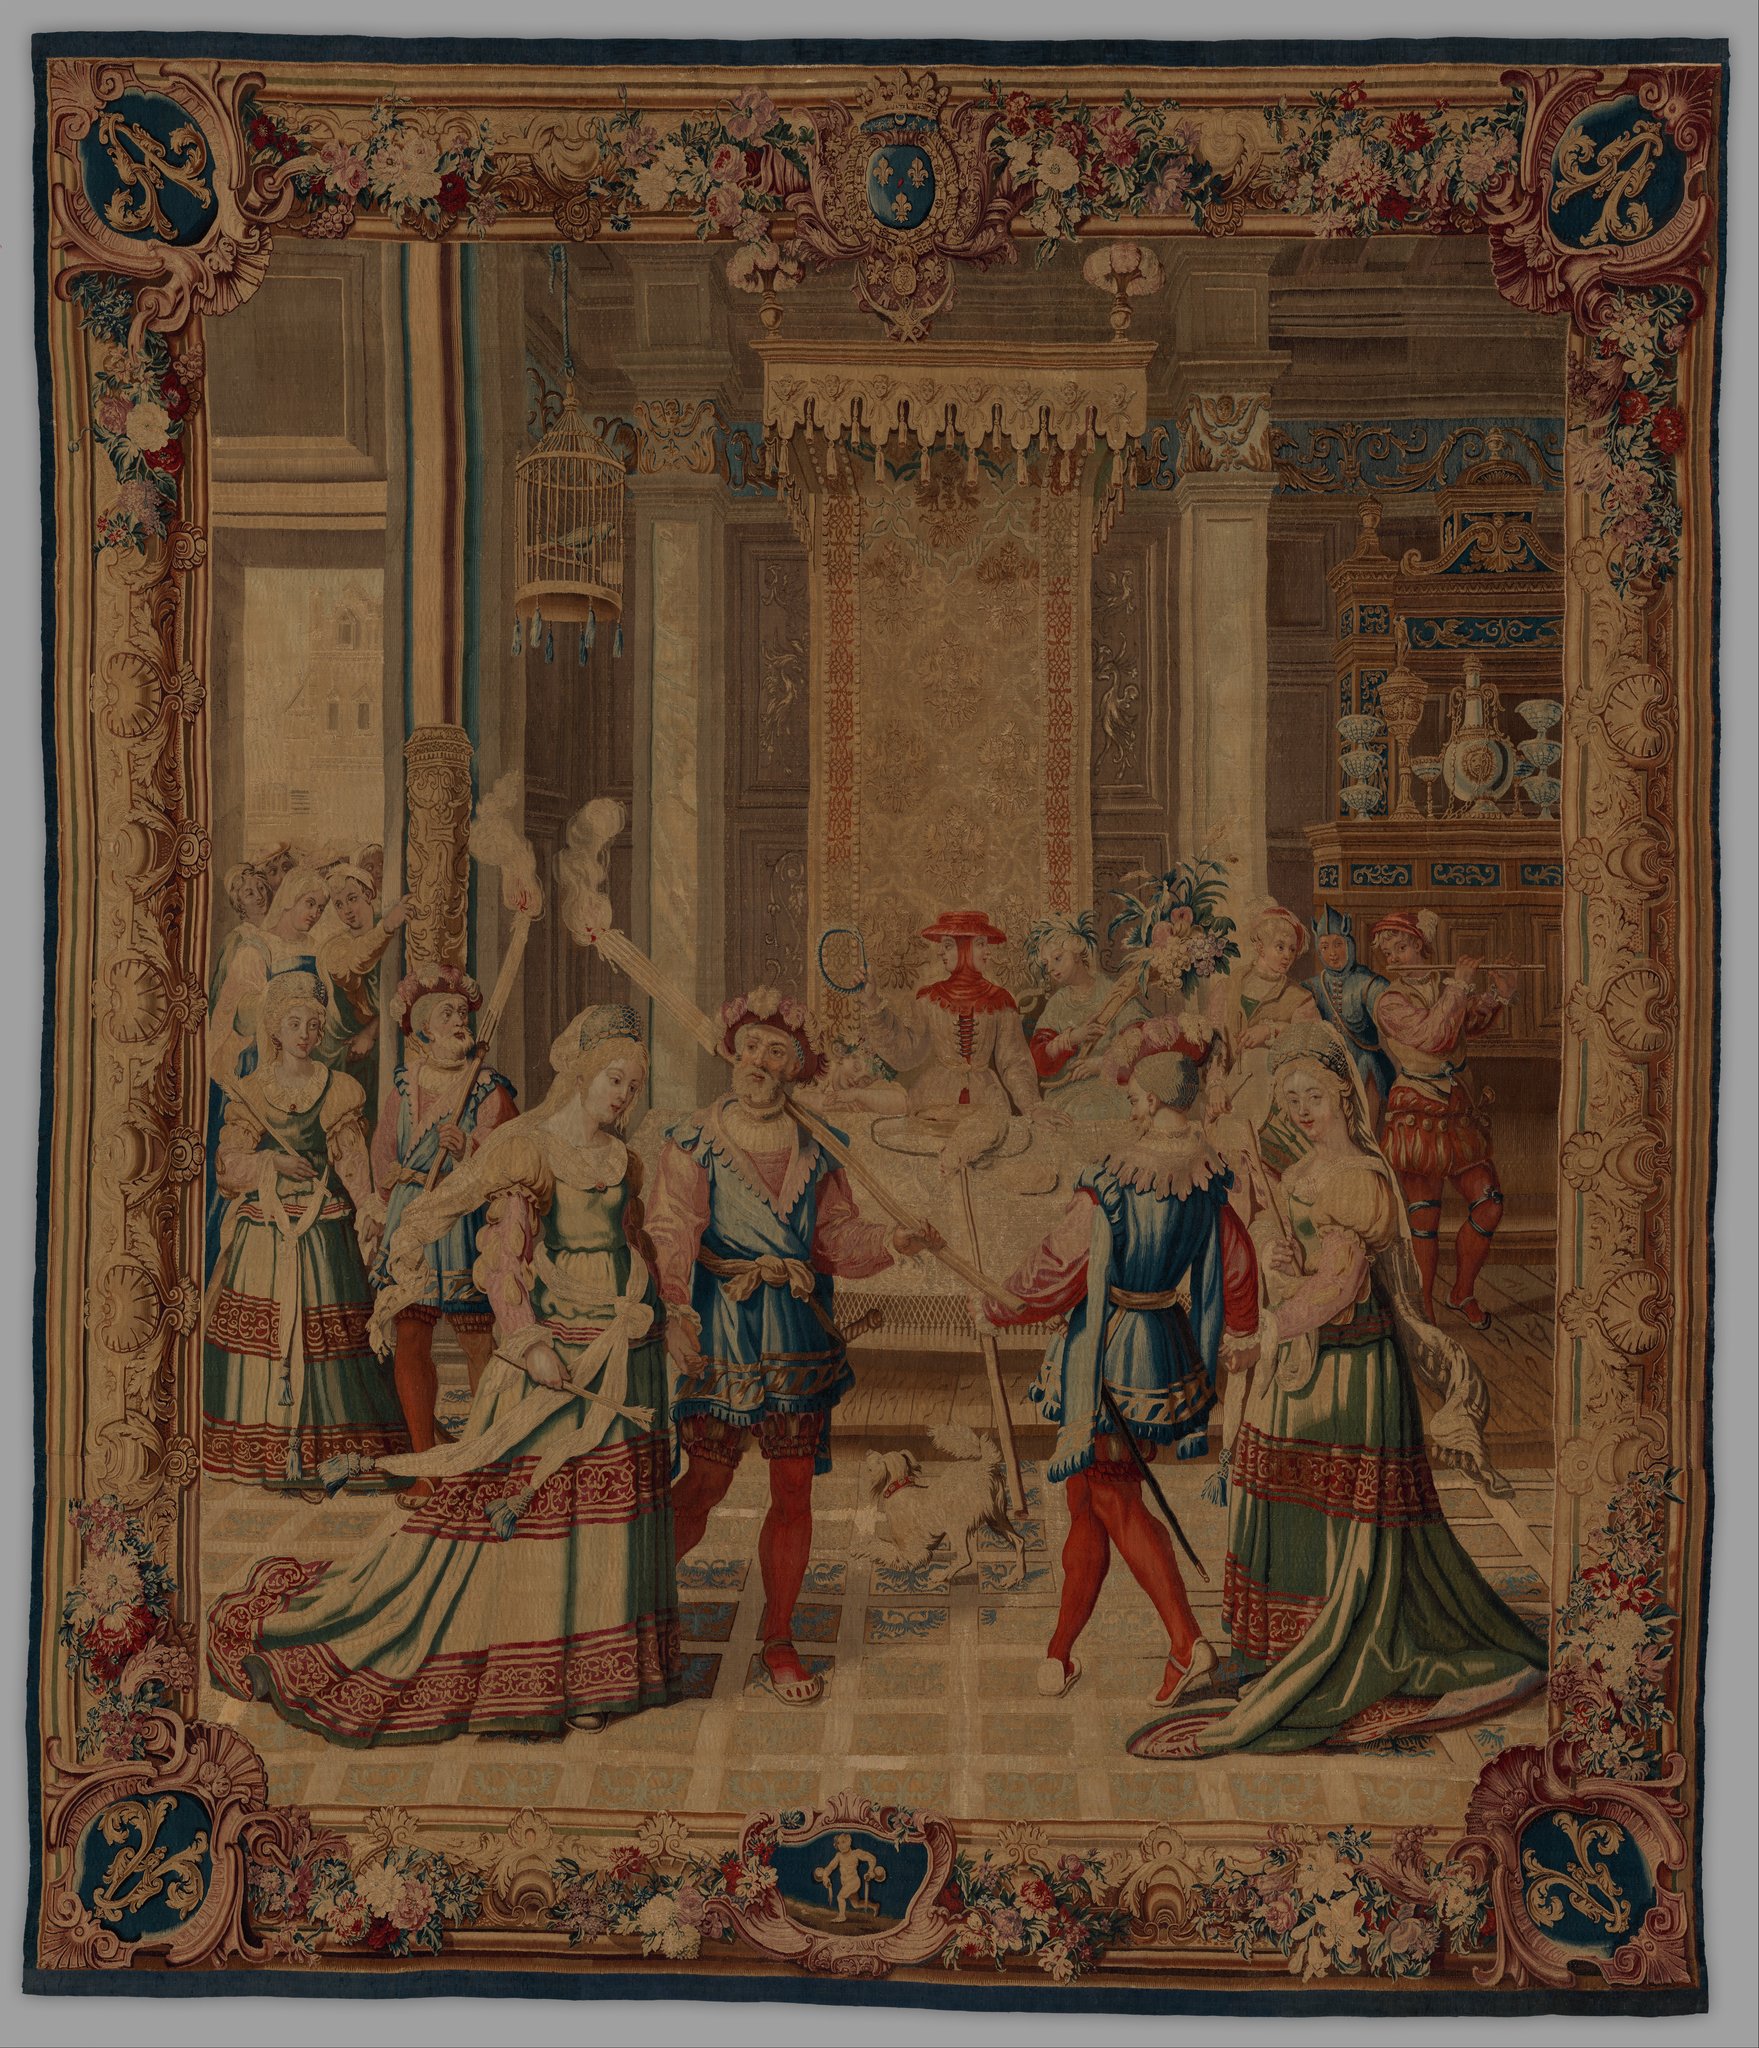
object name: tapestry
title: January from a set of The Months of Lucas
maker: master of the months of lucas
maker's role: designer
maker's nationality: netherlandish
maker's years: 1535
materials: silk, wool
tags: birds,interiors,men,women,dogs